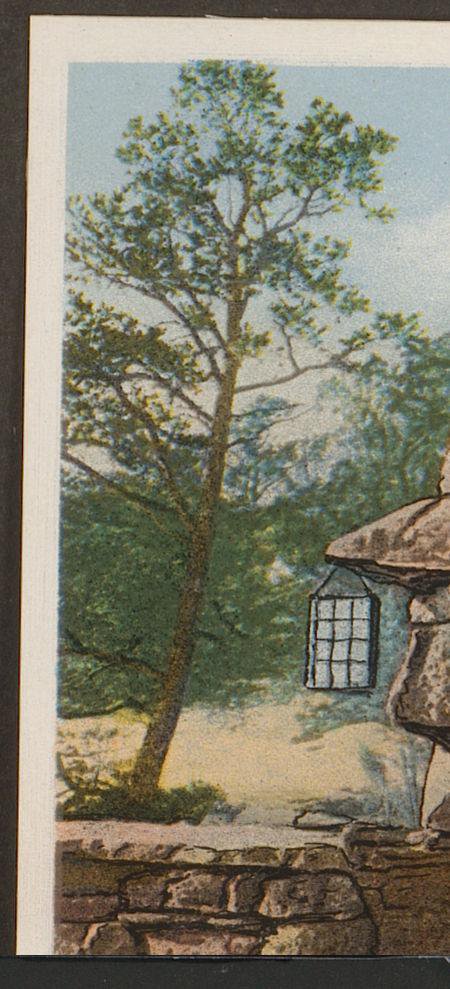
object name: album leaf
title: Vakantiehuizen in Hermit Creek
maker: Anonymous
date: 1928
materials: photographic support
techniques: gelatin silver print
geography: grand canyon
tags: ravine, chasm, abyss, canyon, civic architecture; edifices; dwellings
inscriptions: annotation: ‘Grand Canyon’